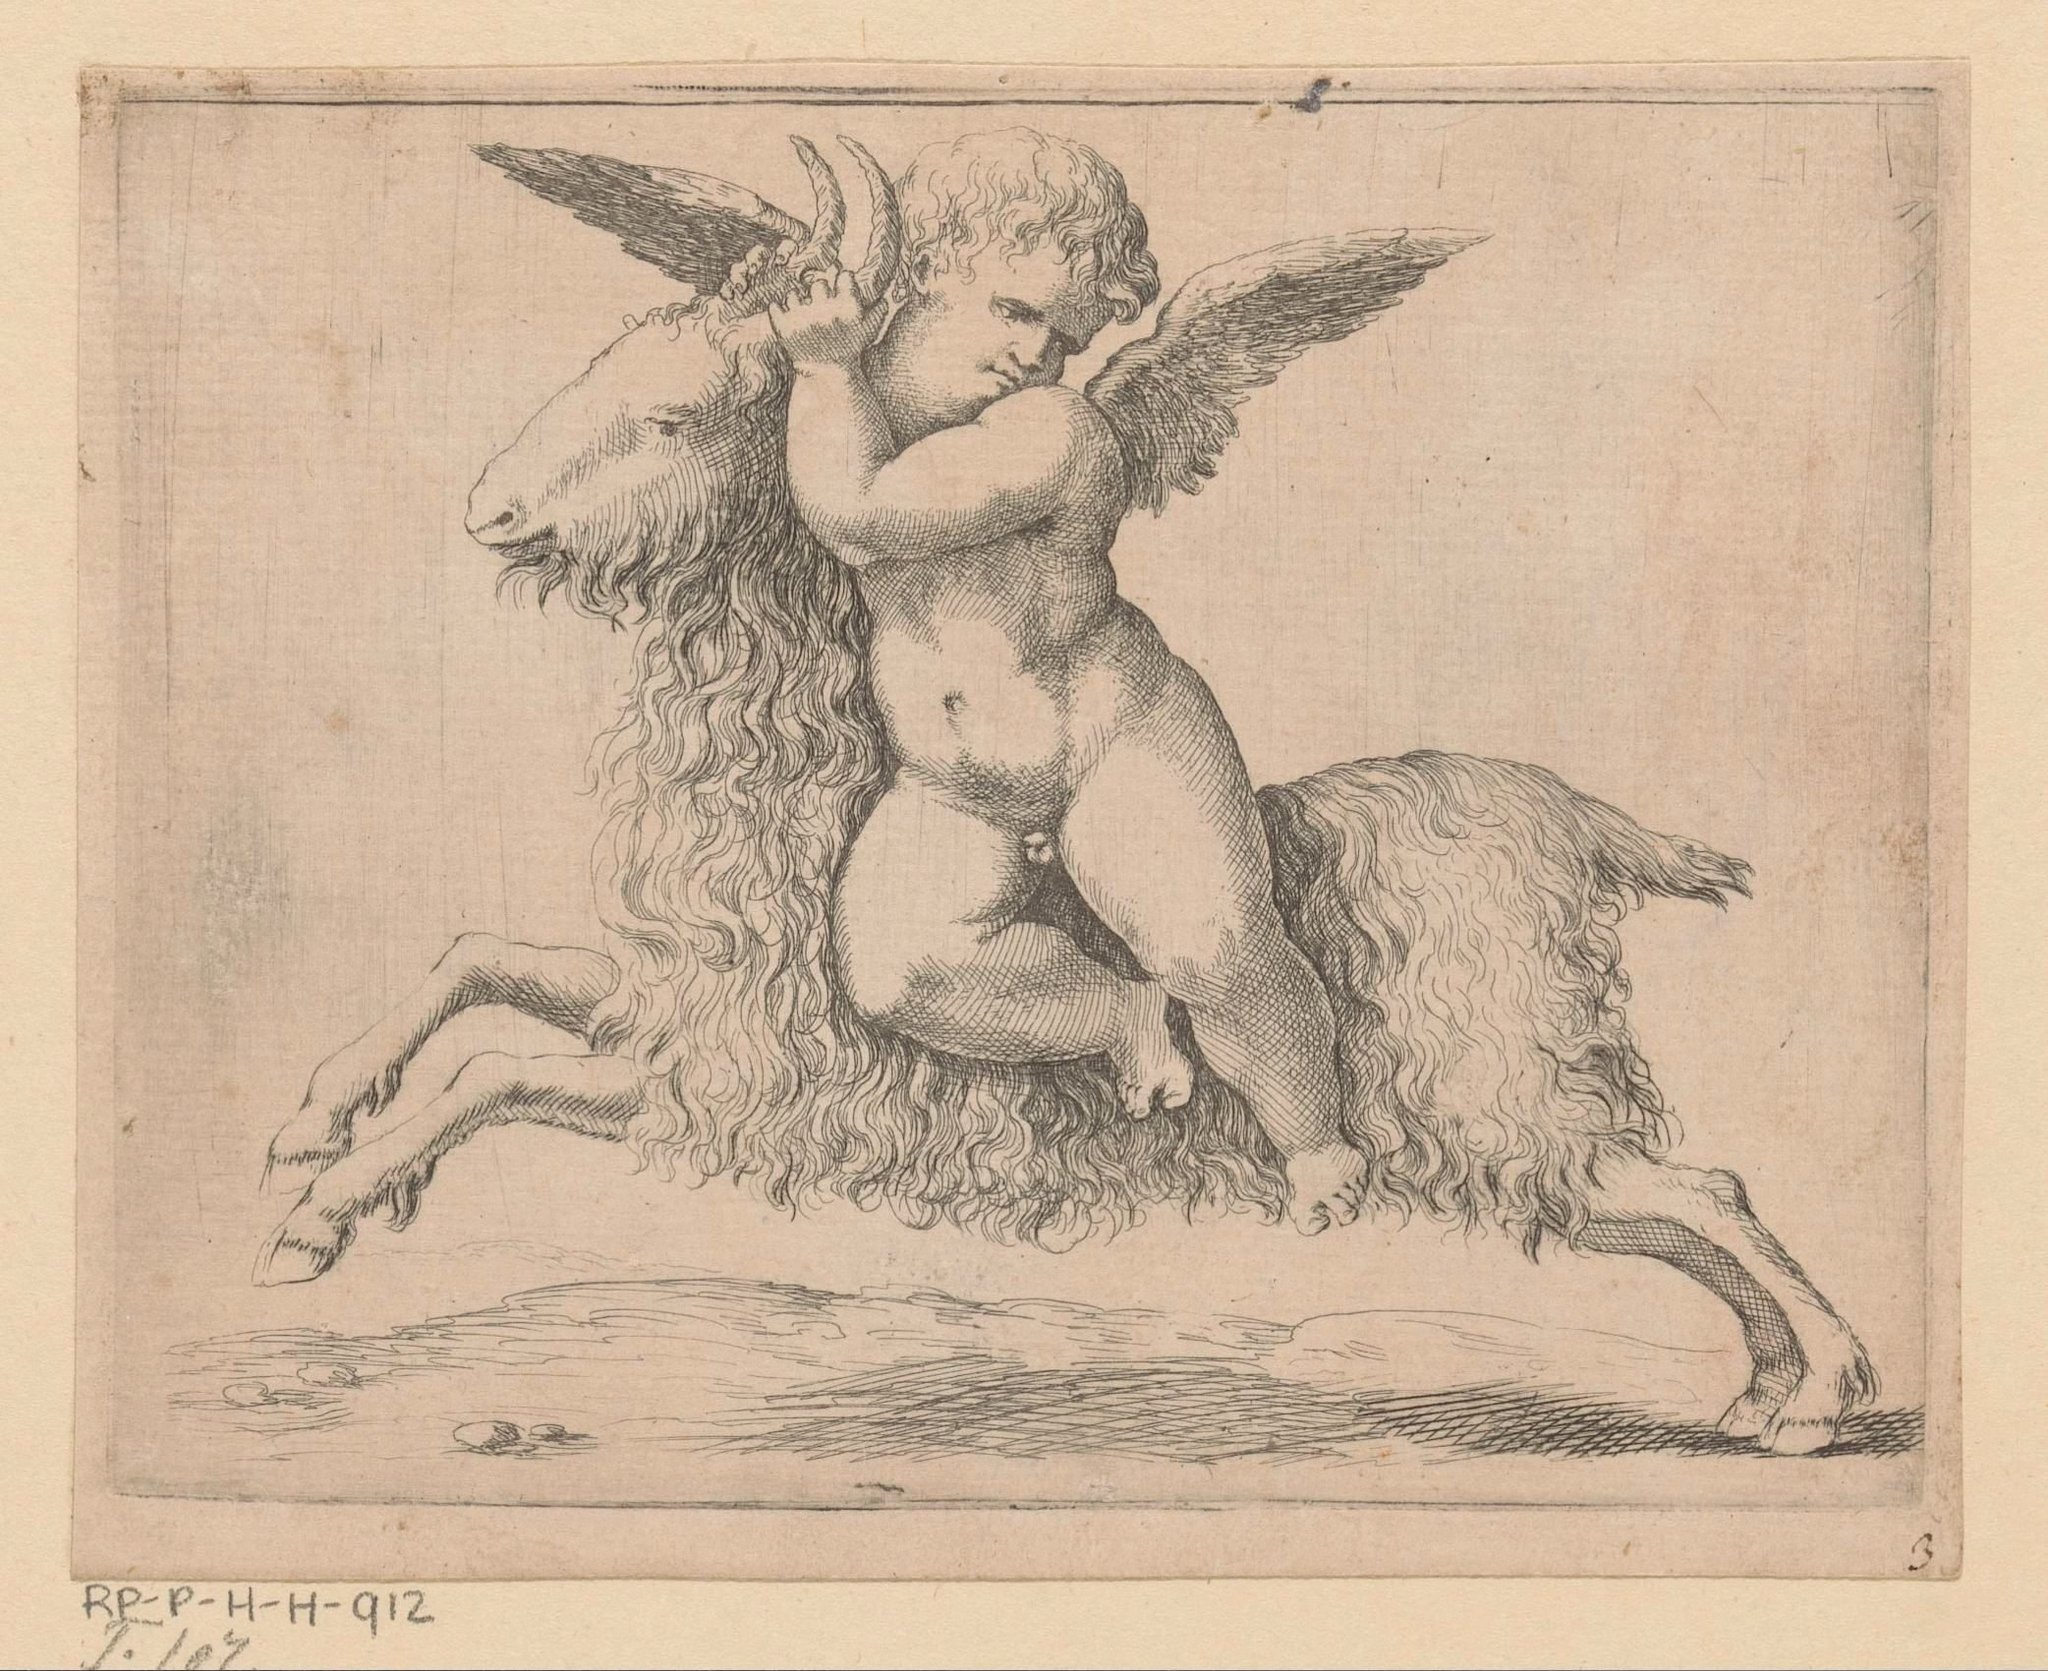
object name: print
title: Putto op een ram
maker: Anonymous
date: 1500-1599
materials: paper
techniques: etching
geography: italy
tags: ram, cupids: 'amores', 'amoretti', 'putti'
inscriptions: number: ‘3’, collector's mark: ‘Hinloopen’, collector's mark: Lugt 11, collector's mark: Lugt 10